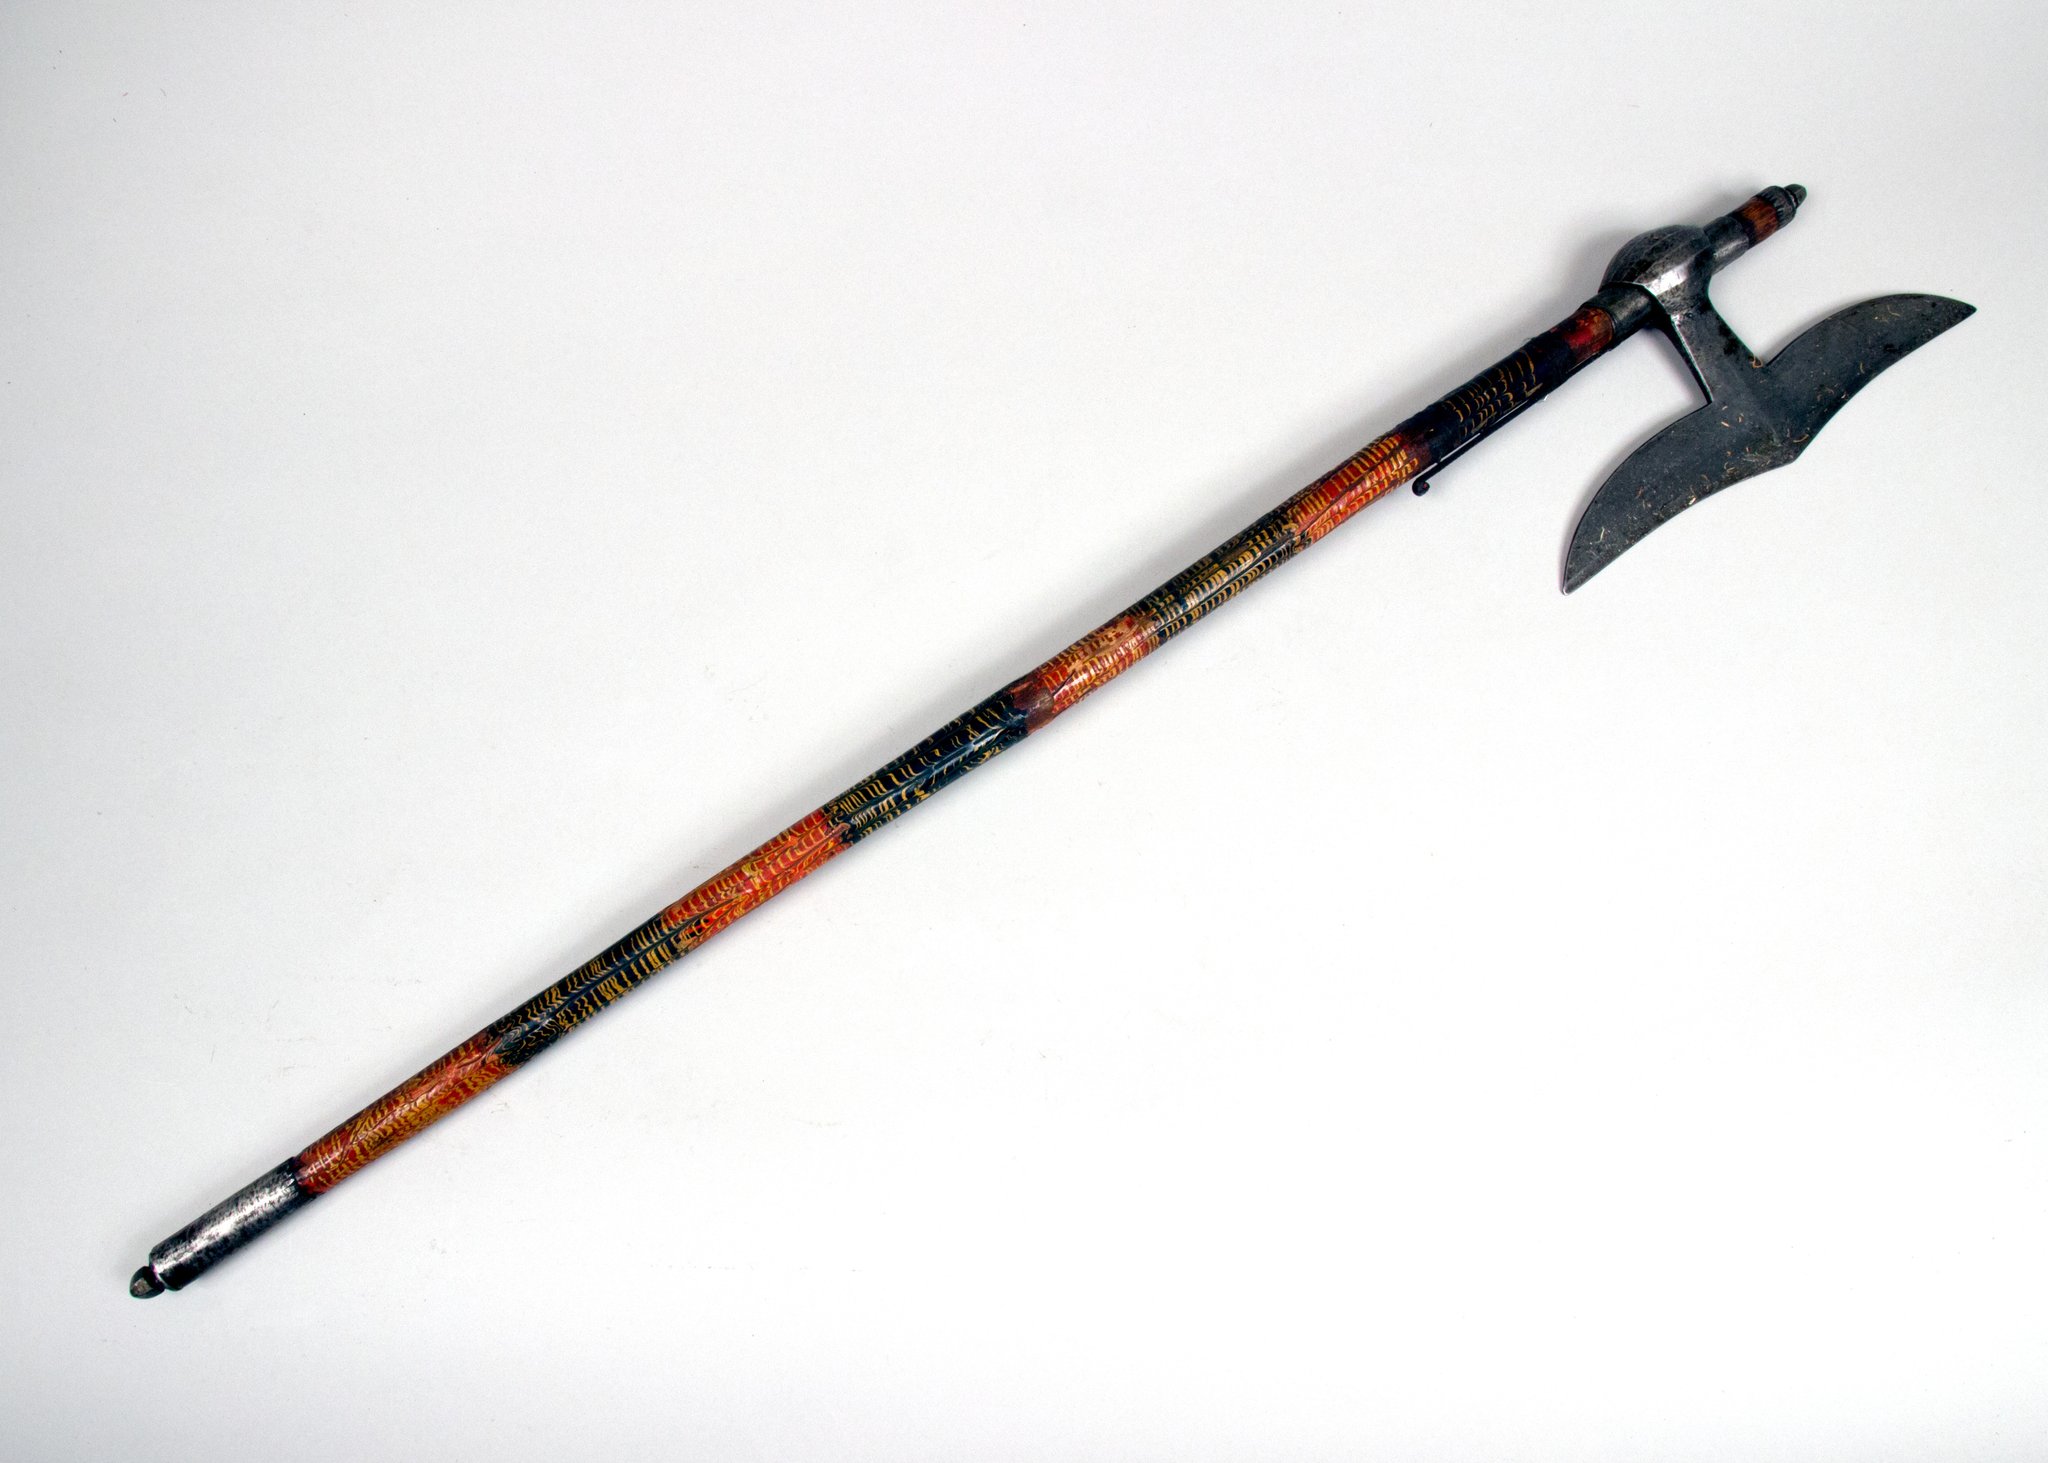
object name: axe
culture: indian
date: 1701-1900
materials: paint, steel, wood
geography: india